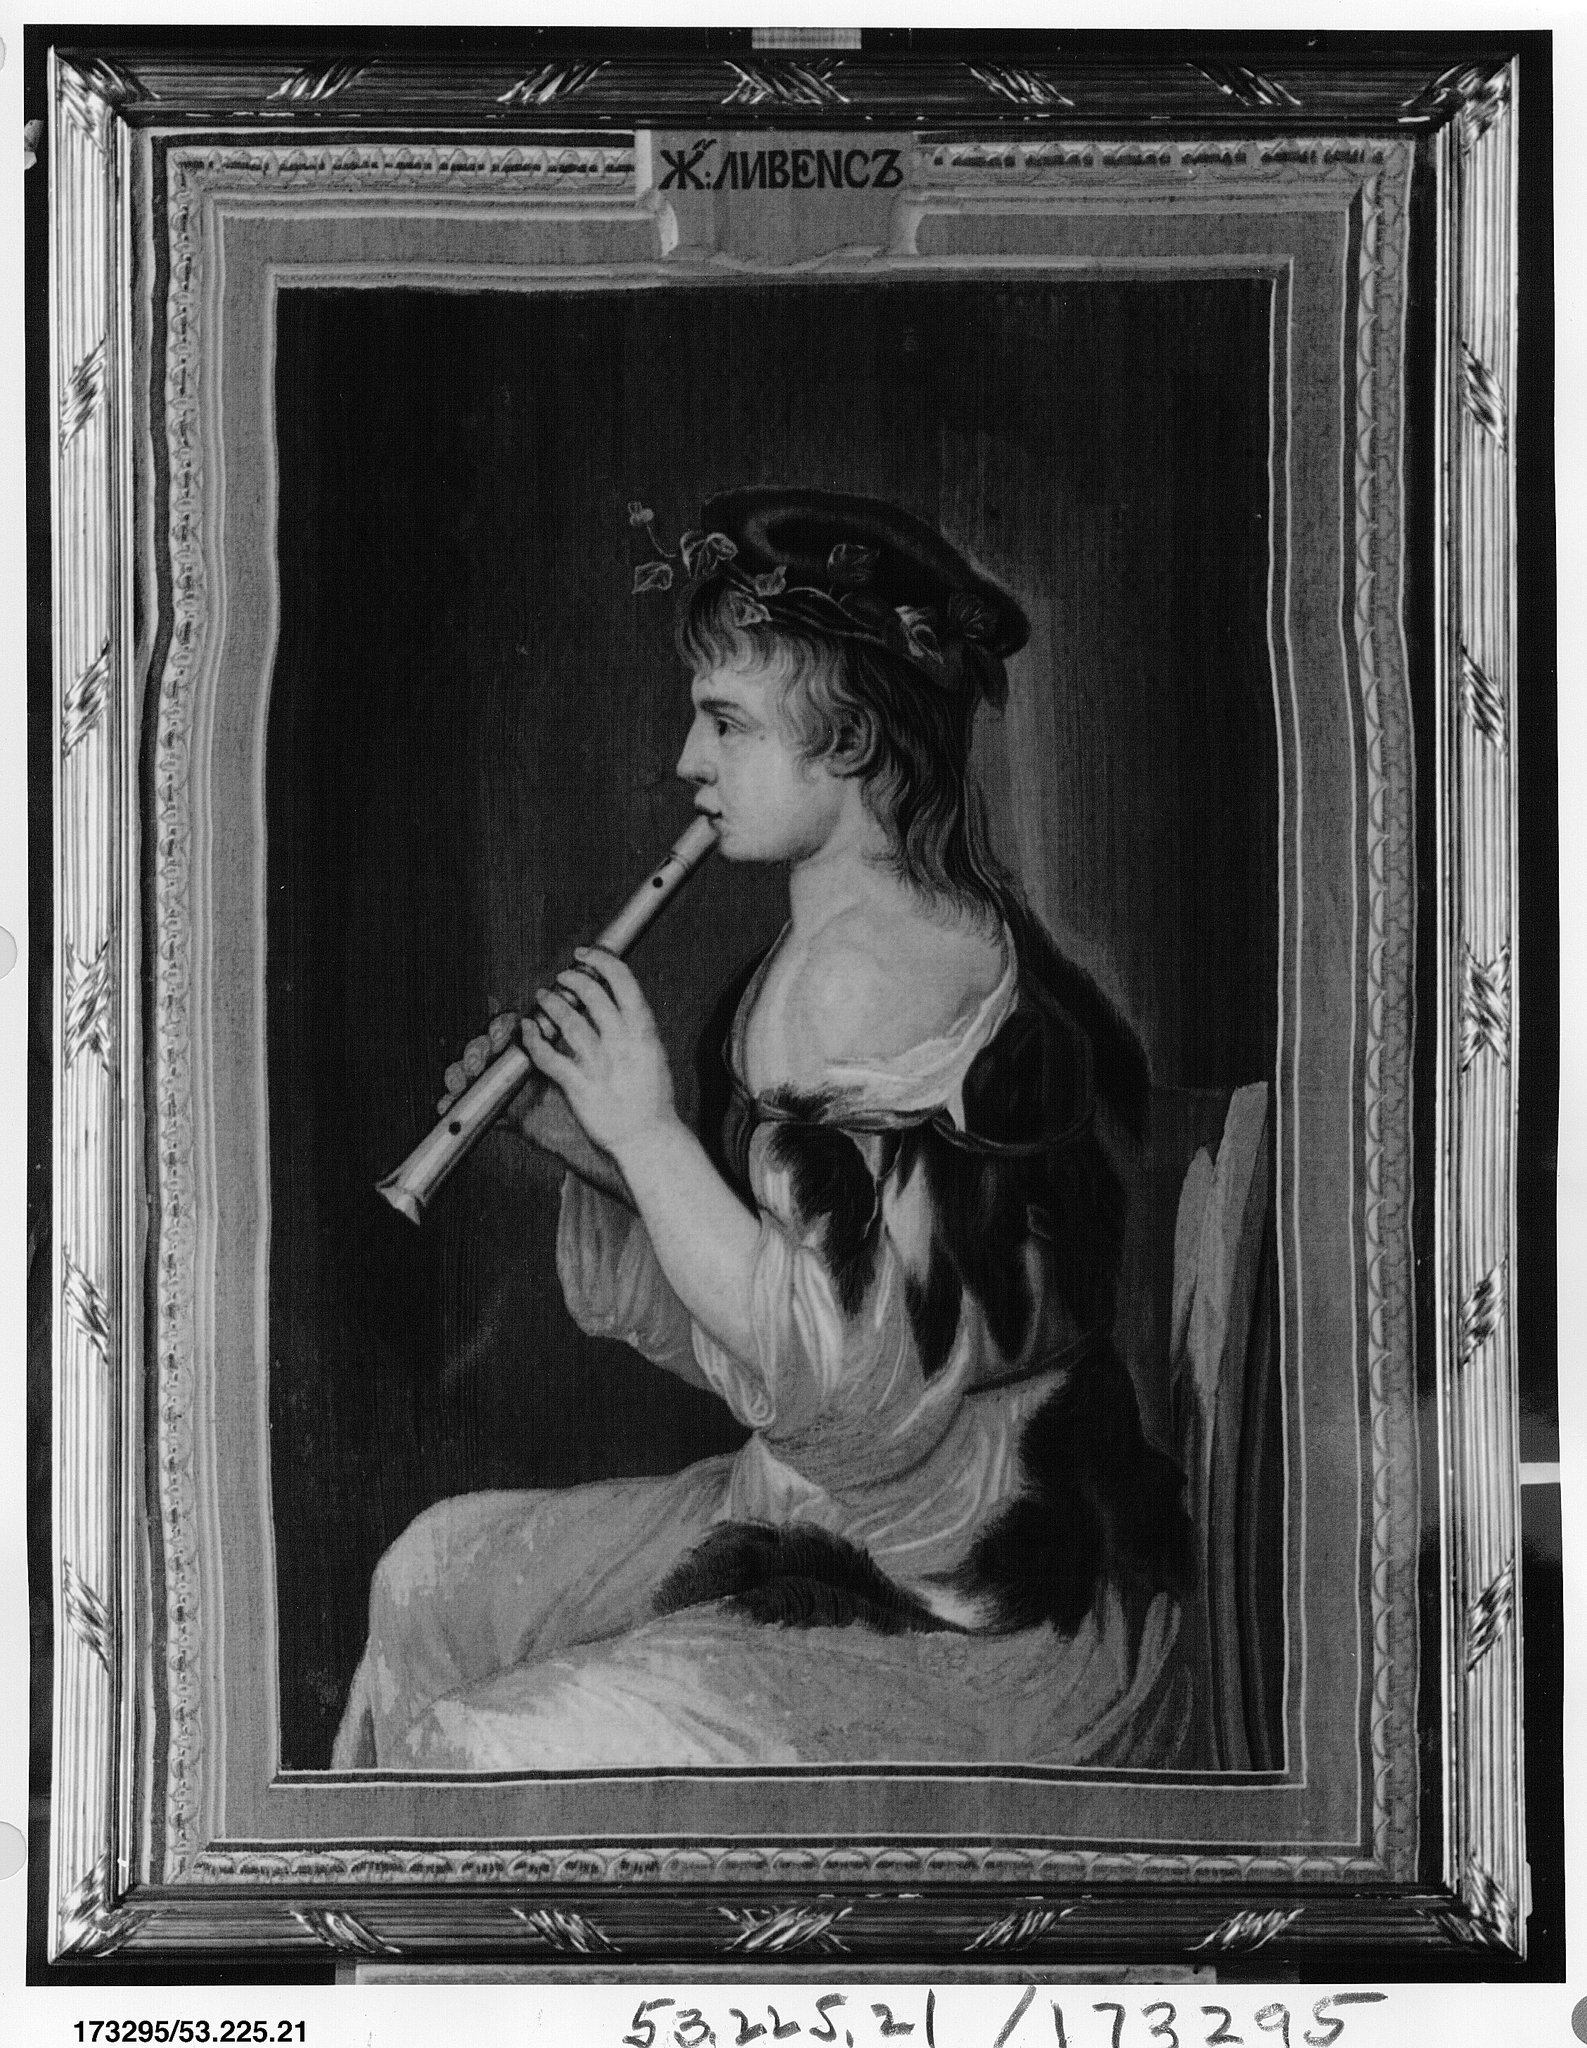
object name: tapestry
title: Girl Playing a Recorder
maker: imperial russian tapestry manufactory, saint petersburg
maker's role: manufactory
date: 1767-1800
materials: metal thread, wool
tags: musical instruments,girls